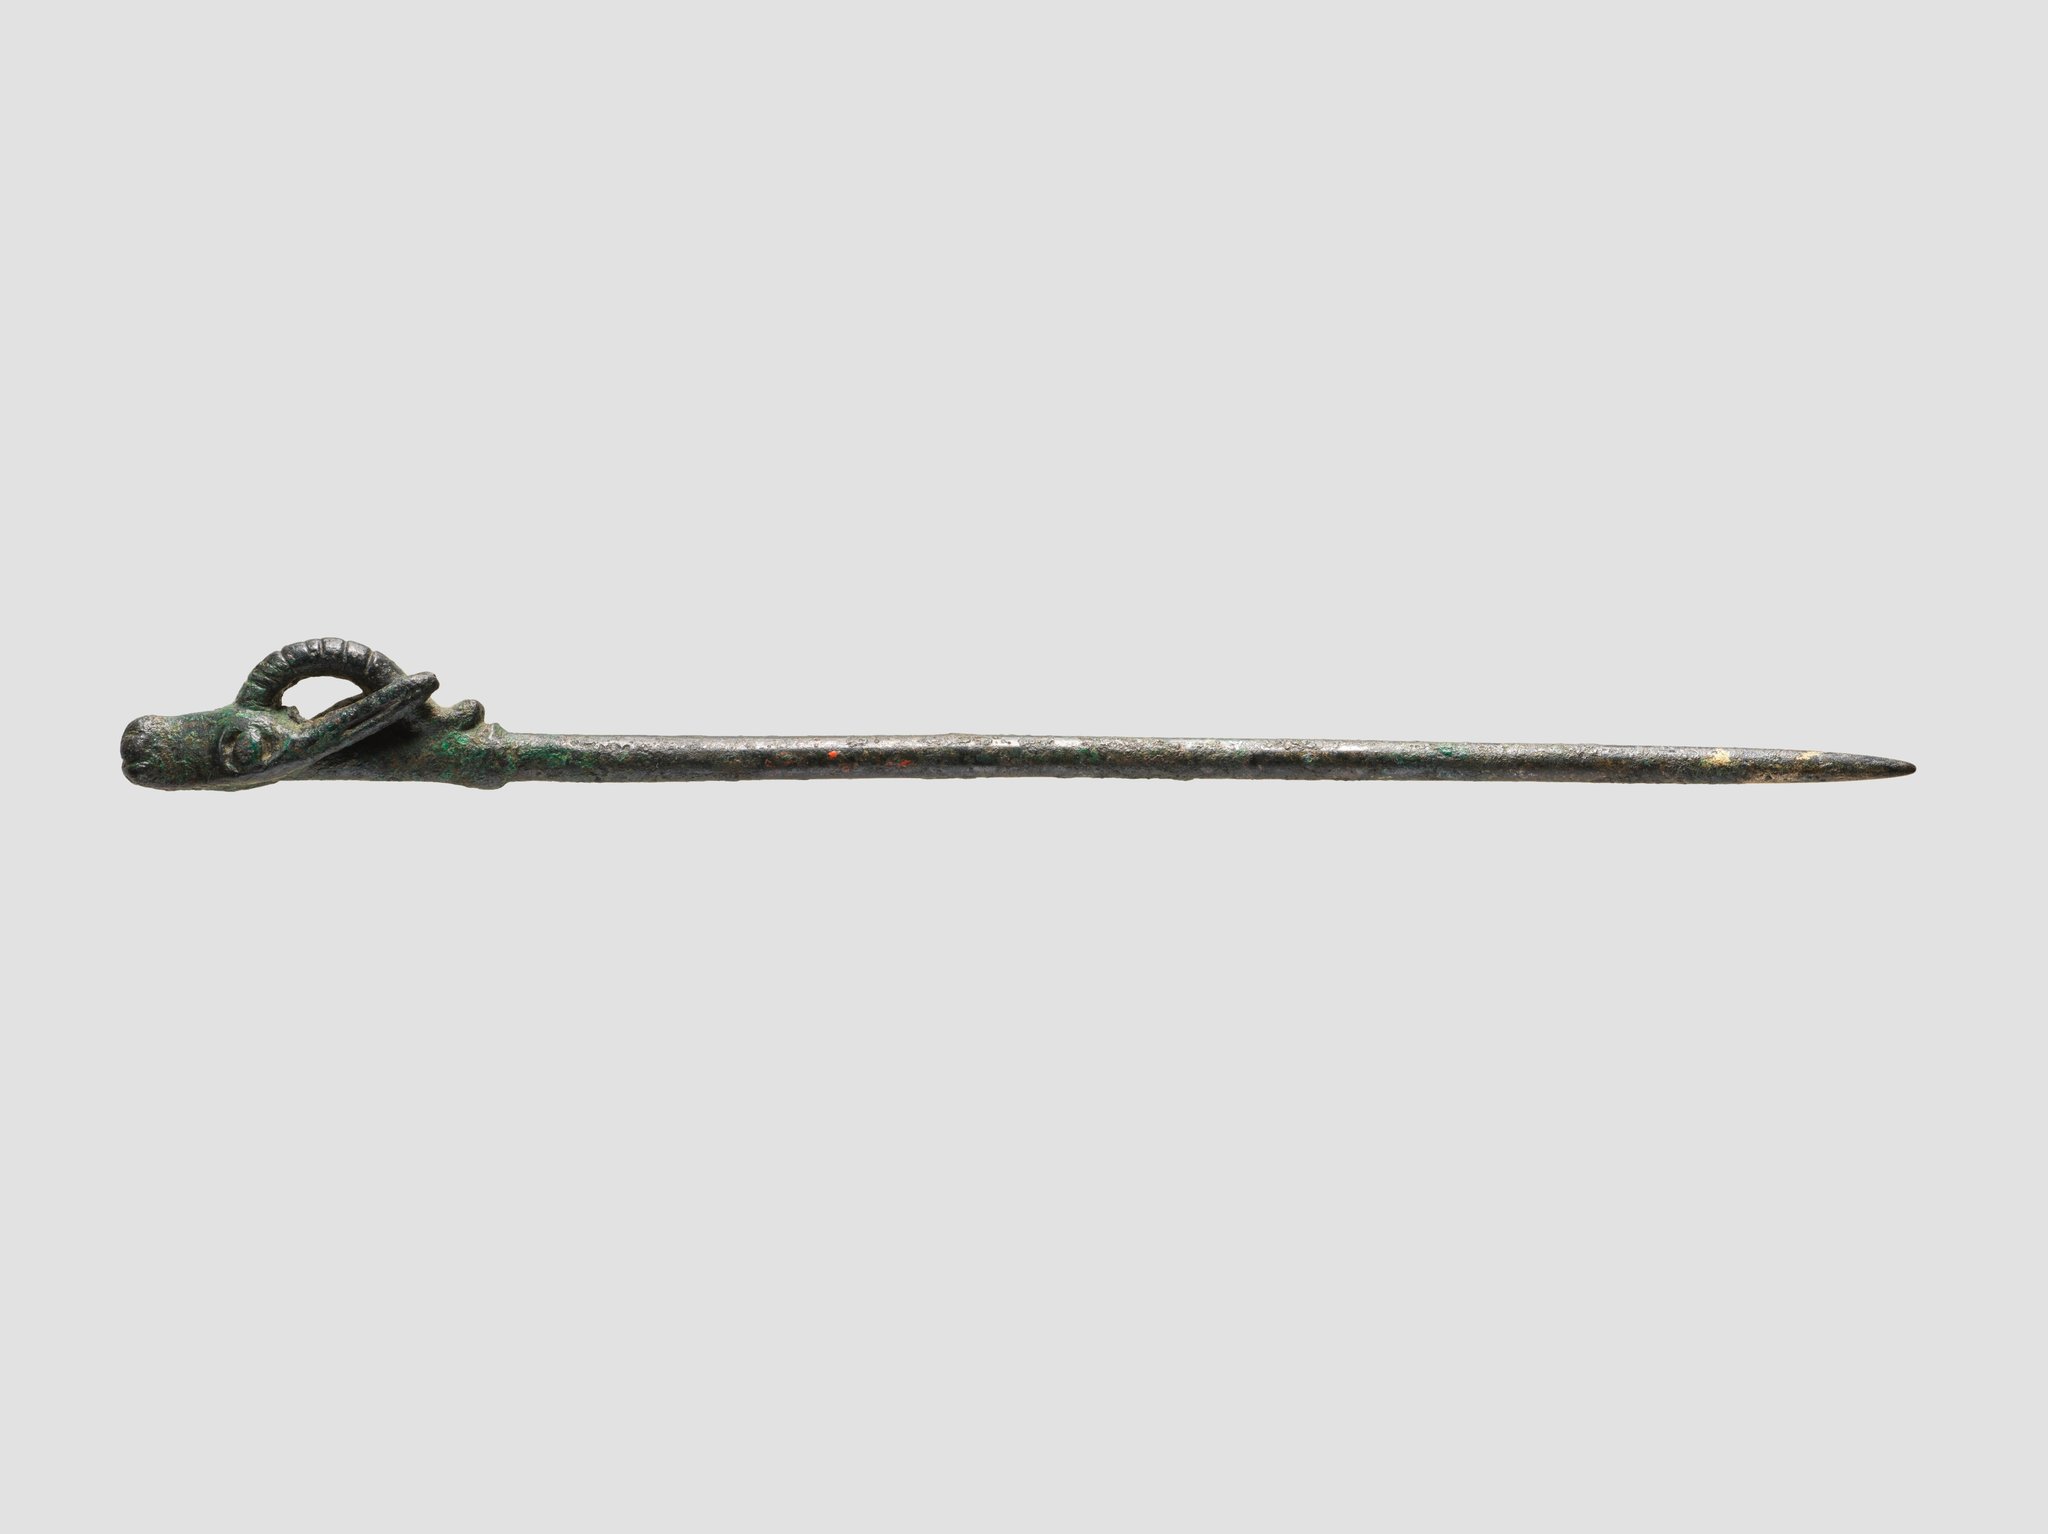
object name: pin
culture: iranian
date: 800-601 BCE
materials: bronze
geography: iran, probably from luristan